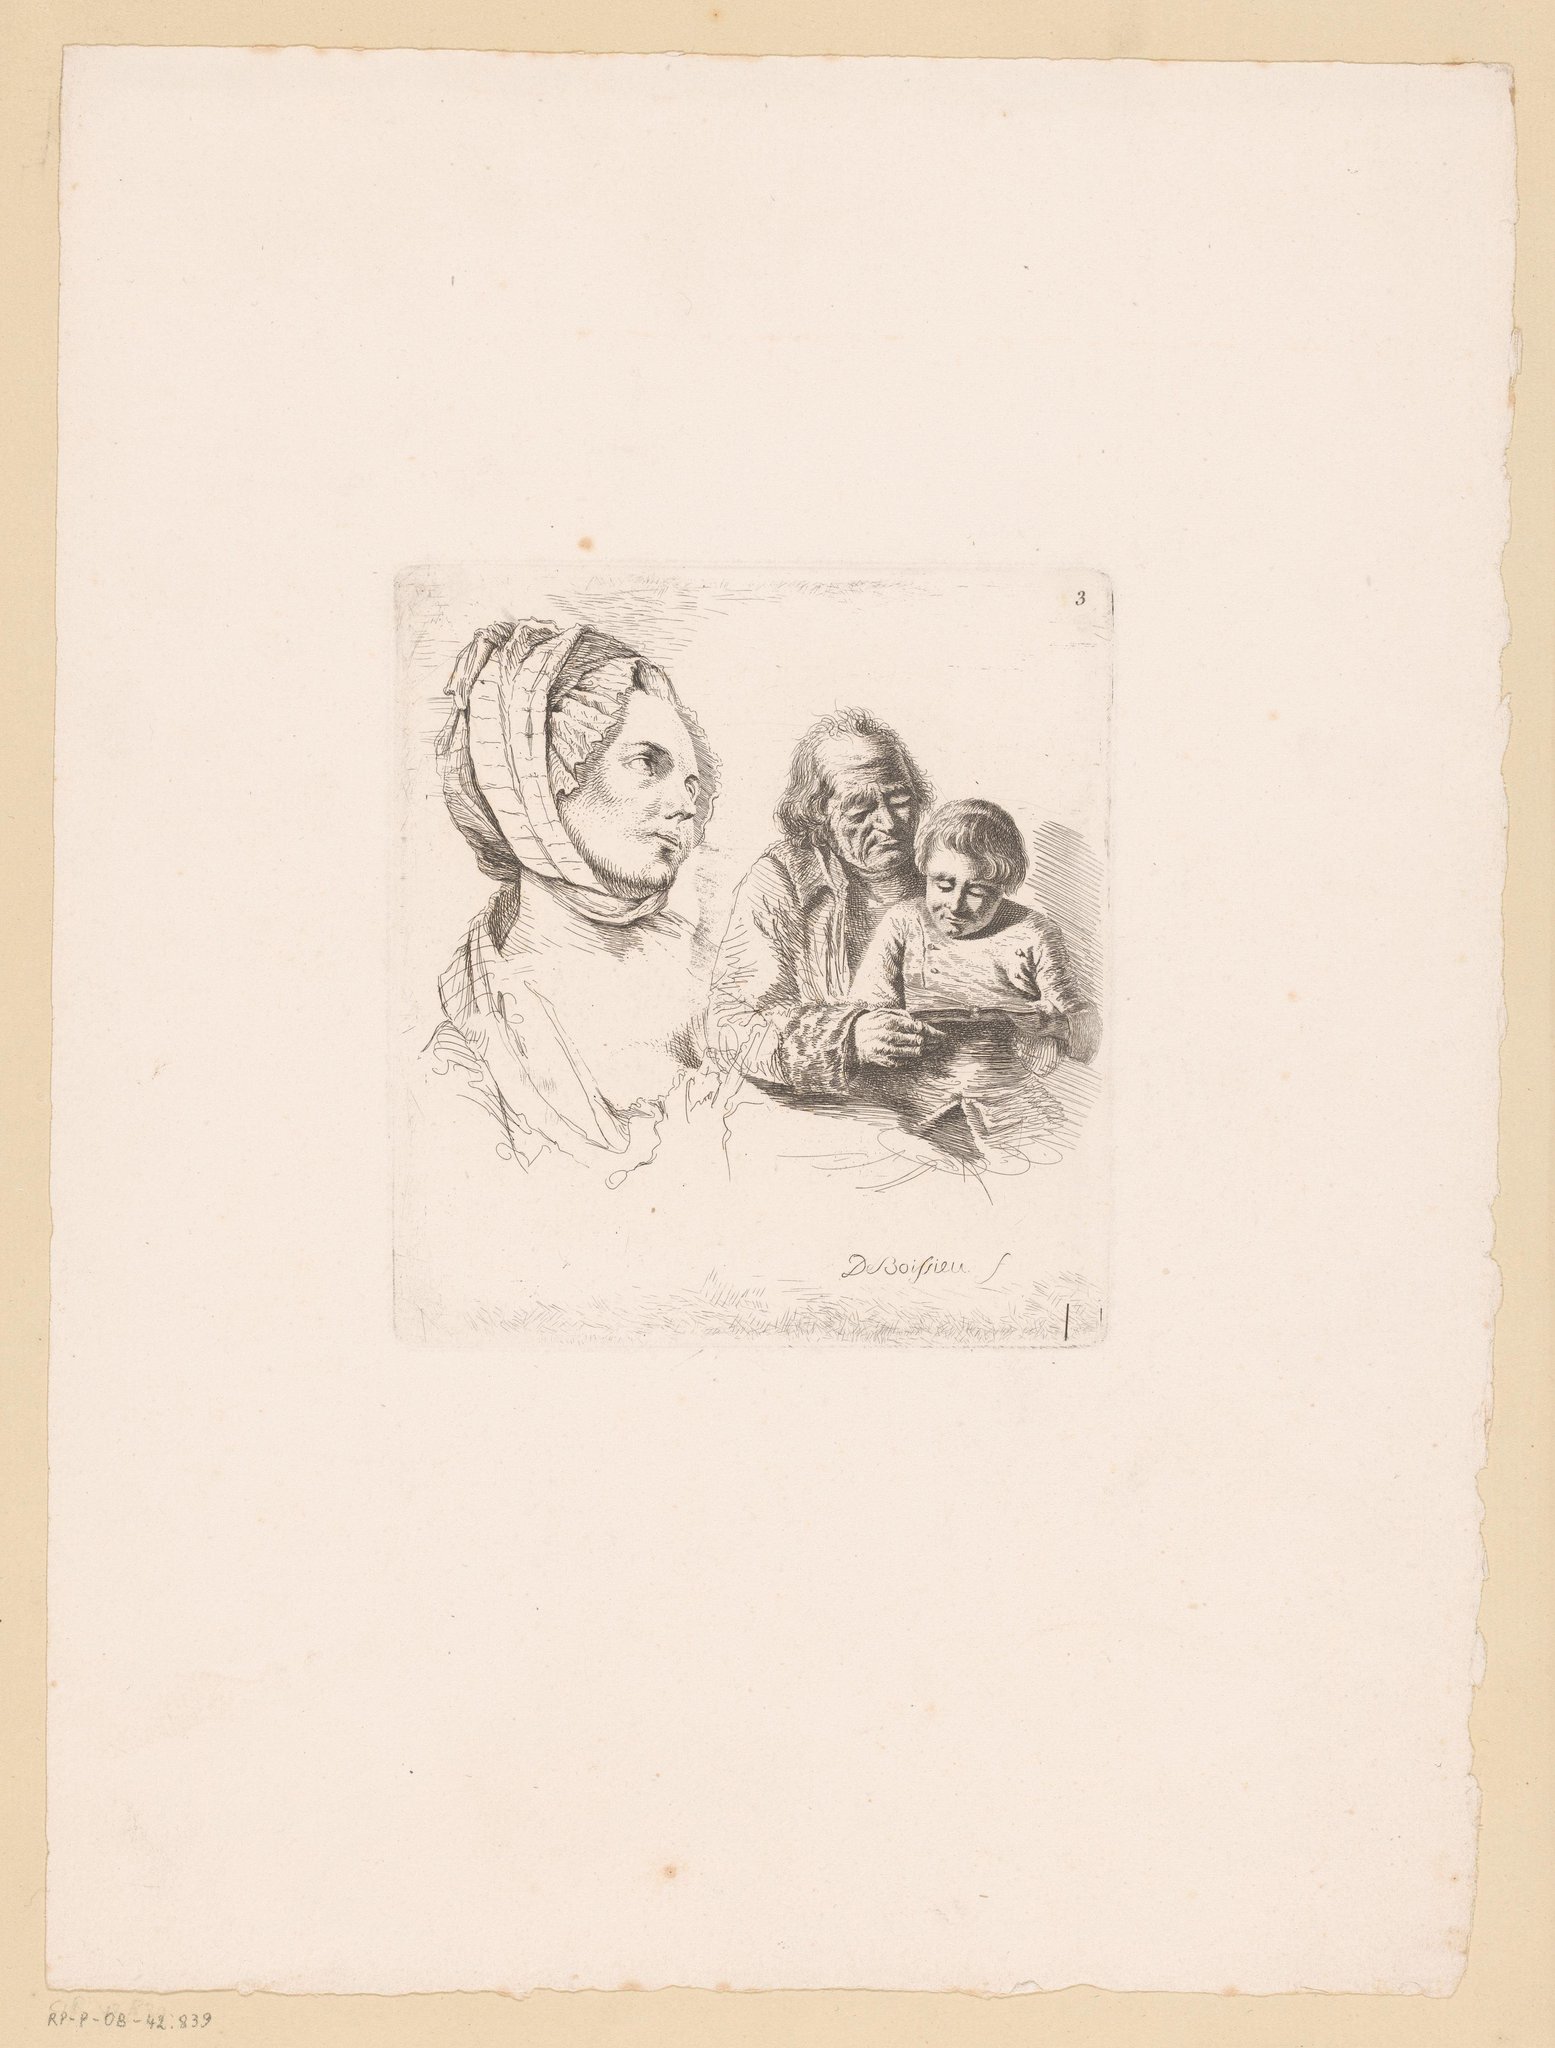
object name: print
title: Compositie met hoofd van een vrouw en een oude man met kind op de schoot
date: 1805-1844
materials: paper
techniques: engraving, etching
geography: france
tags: reading, grandparent(s) with grandchild(ren) (family group), head (human) - aa - female human figure